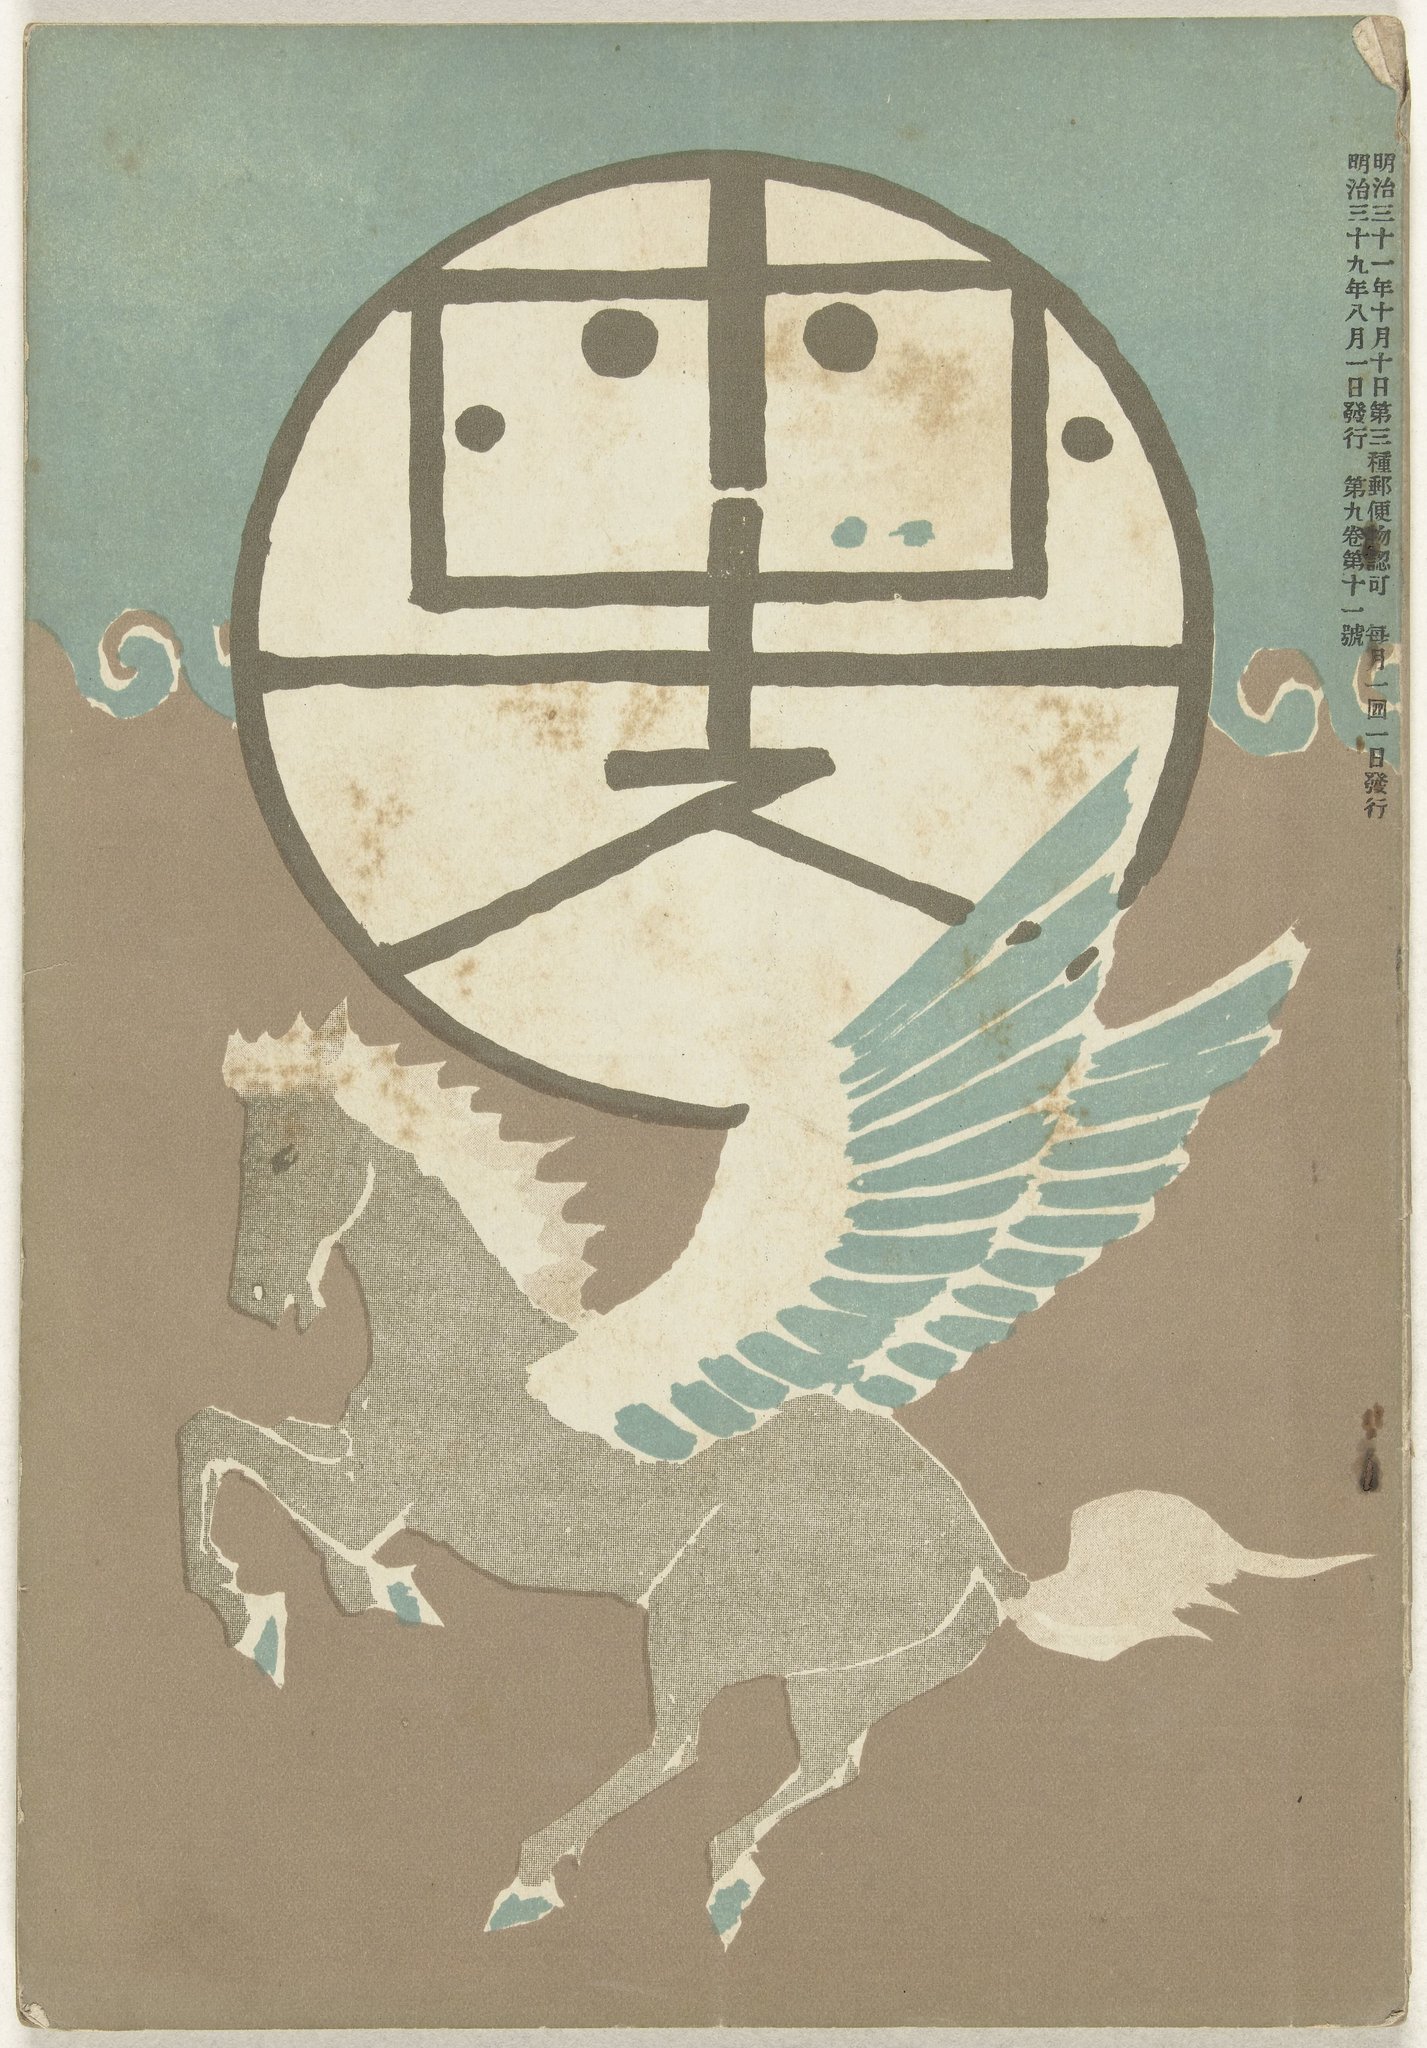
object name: magazine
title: Hototogisu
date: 1906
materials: paper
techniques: woodcut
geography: japan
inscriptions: date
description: Nummer 11 van jaargang 9 (augustus 1906) van het literaire maandblad Hototogisu: kaft met afbeelding van gevleugeld paard tegen bruine achtergrond met blauwe lucht; achterkant, afbeelding van landschap met man in boot.